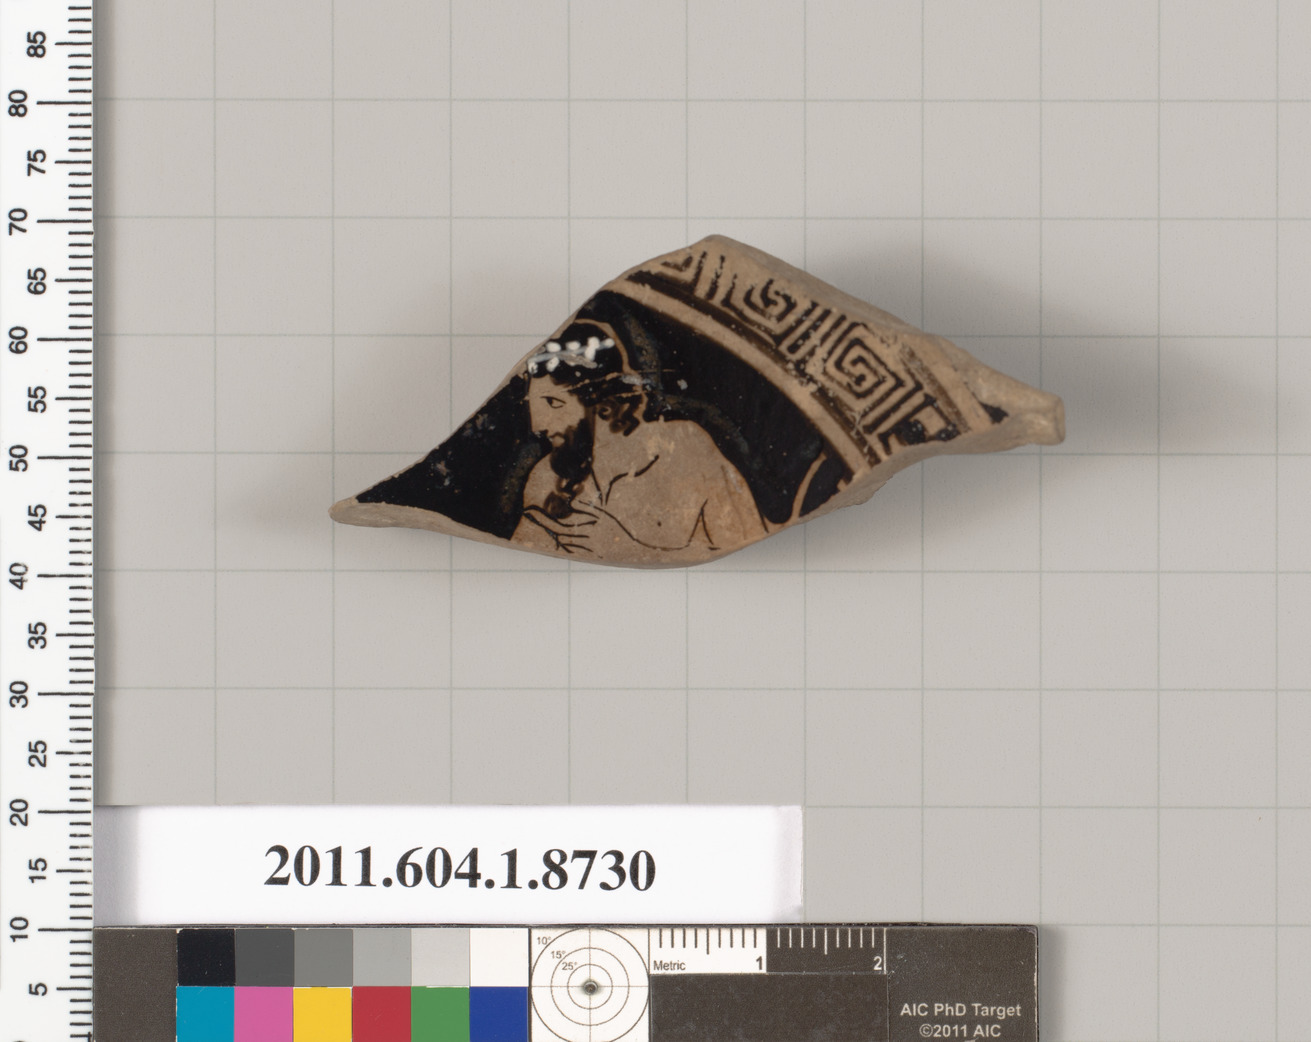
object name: kylix fragment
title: Terracotta fragment of a stemless cup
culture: greek, attic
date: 470-460 BCE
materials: terracotta